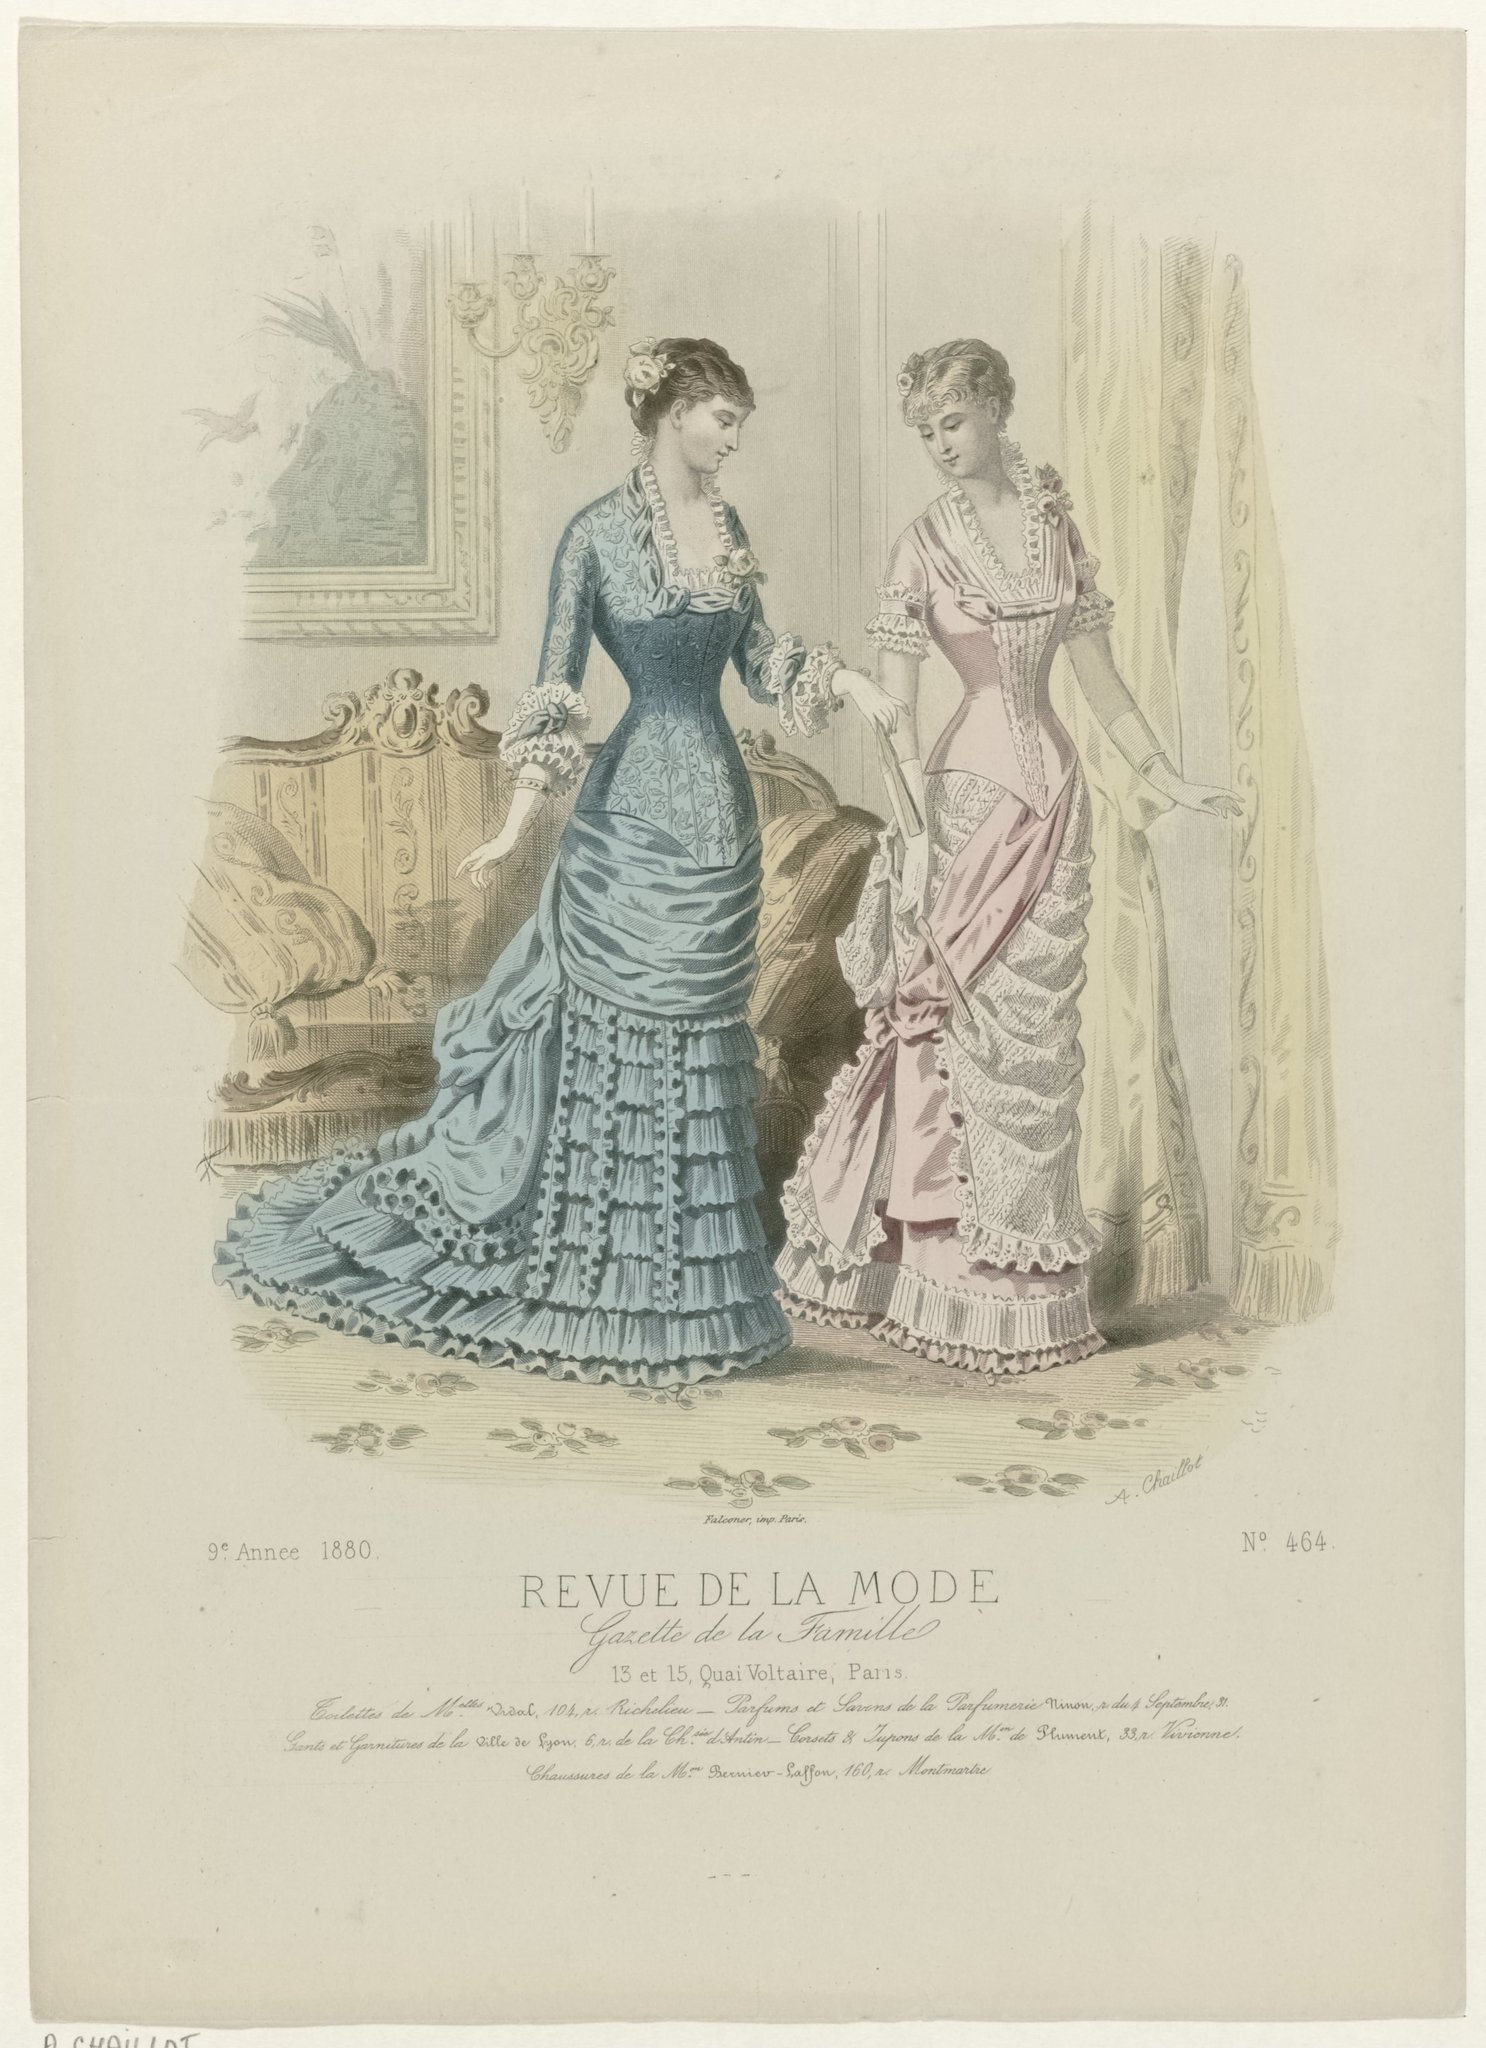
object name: fashion print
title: Revue de la Mode, Gazette de la Famille, dimanche 21 novembre 1880, 9e année, No. 464: Toilettes de M.elles Vidal (...)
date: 1880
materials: paper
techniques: engraving, hand coloring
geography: paris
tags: corsage (+ women's clothes), gloves, mittens (long gloves) (+ women's clothes), dress, gown: ball gown (+ women's clothes), lace (+ women's clothes), dress, gown: dinner dress (+ women's clothes), fashion plates, fan (+ women's clothes), flowers: rose, couch, sofa, settee, bracelet, wristlet (+ women's clothes)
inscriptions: caption: ‘Toilettes de la M.elles Vidal, 104, r. Richelieu_Parfums et Savons de la Parfumerie Ninon, 31, r. du 4 Septembre_Gants & Garnitures de la Ville de Lyon, 6. r. de la Ch.sée d'Antin_ Corsets & Jupons de la M.on de Plument. 33. r. Vivienne_Chaussures de la M.on Bernier-Laffon, 160, r. Montmartre.’, title: ‘REVUE DE LA MODE / Gazette de la Famille’, address: ‘13 et 15, Quai Voltaire, Paris’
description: Twee vrouwen in een interieur in japonnen van Vidal. Links: japon voor een diner of receptie van blauwe satijn brokaat en gaas. Rechts: baljapon van roze satijn en wit gebrocheerd gaas, geschikt voor een meisje of jonge vrouw . Lange handschoenen zonder knopen van wit suède. Onderschrift met enkele regels reclametekst voor verschillende producten. Prent uit het modetijdschrift Revue de la Mode (1872-1913). Uitgebreide beschrijving van de kleding op pagina 388 en 389 "PLANCHE COLORIÉE".